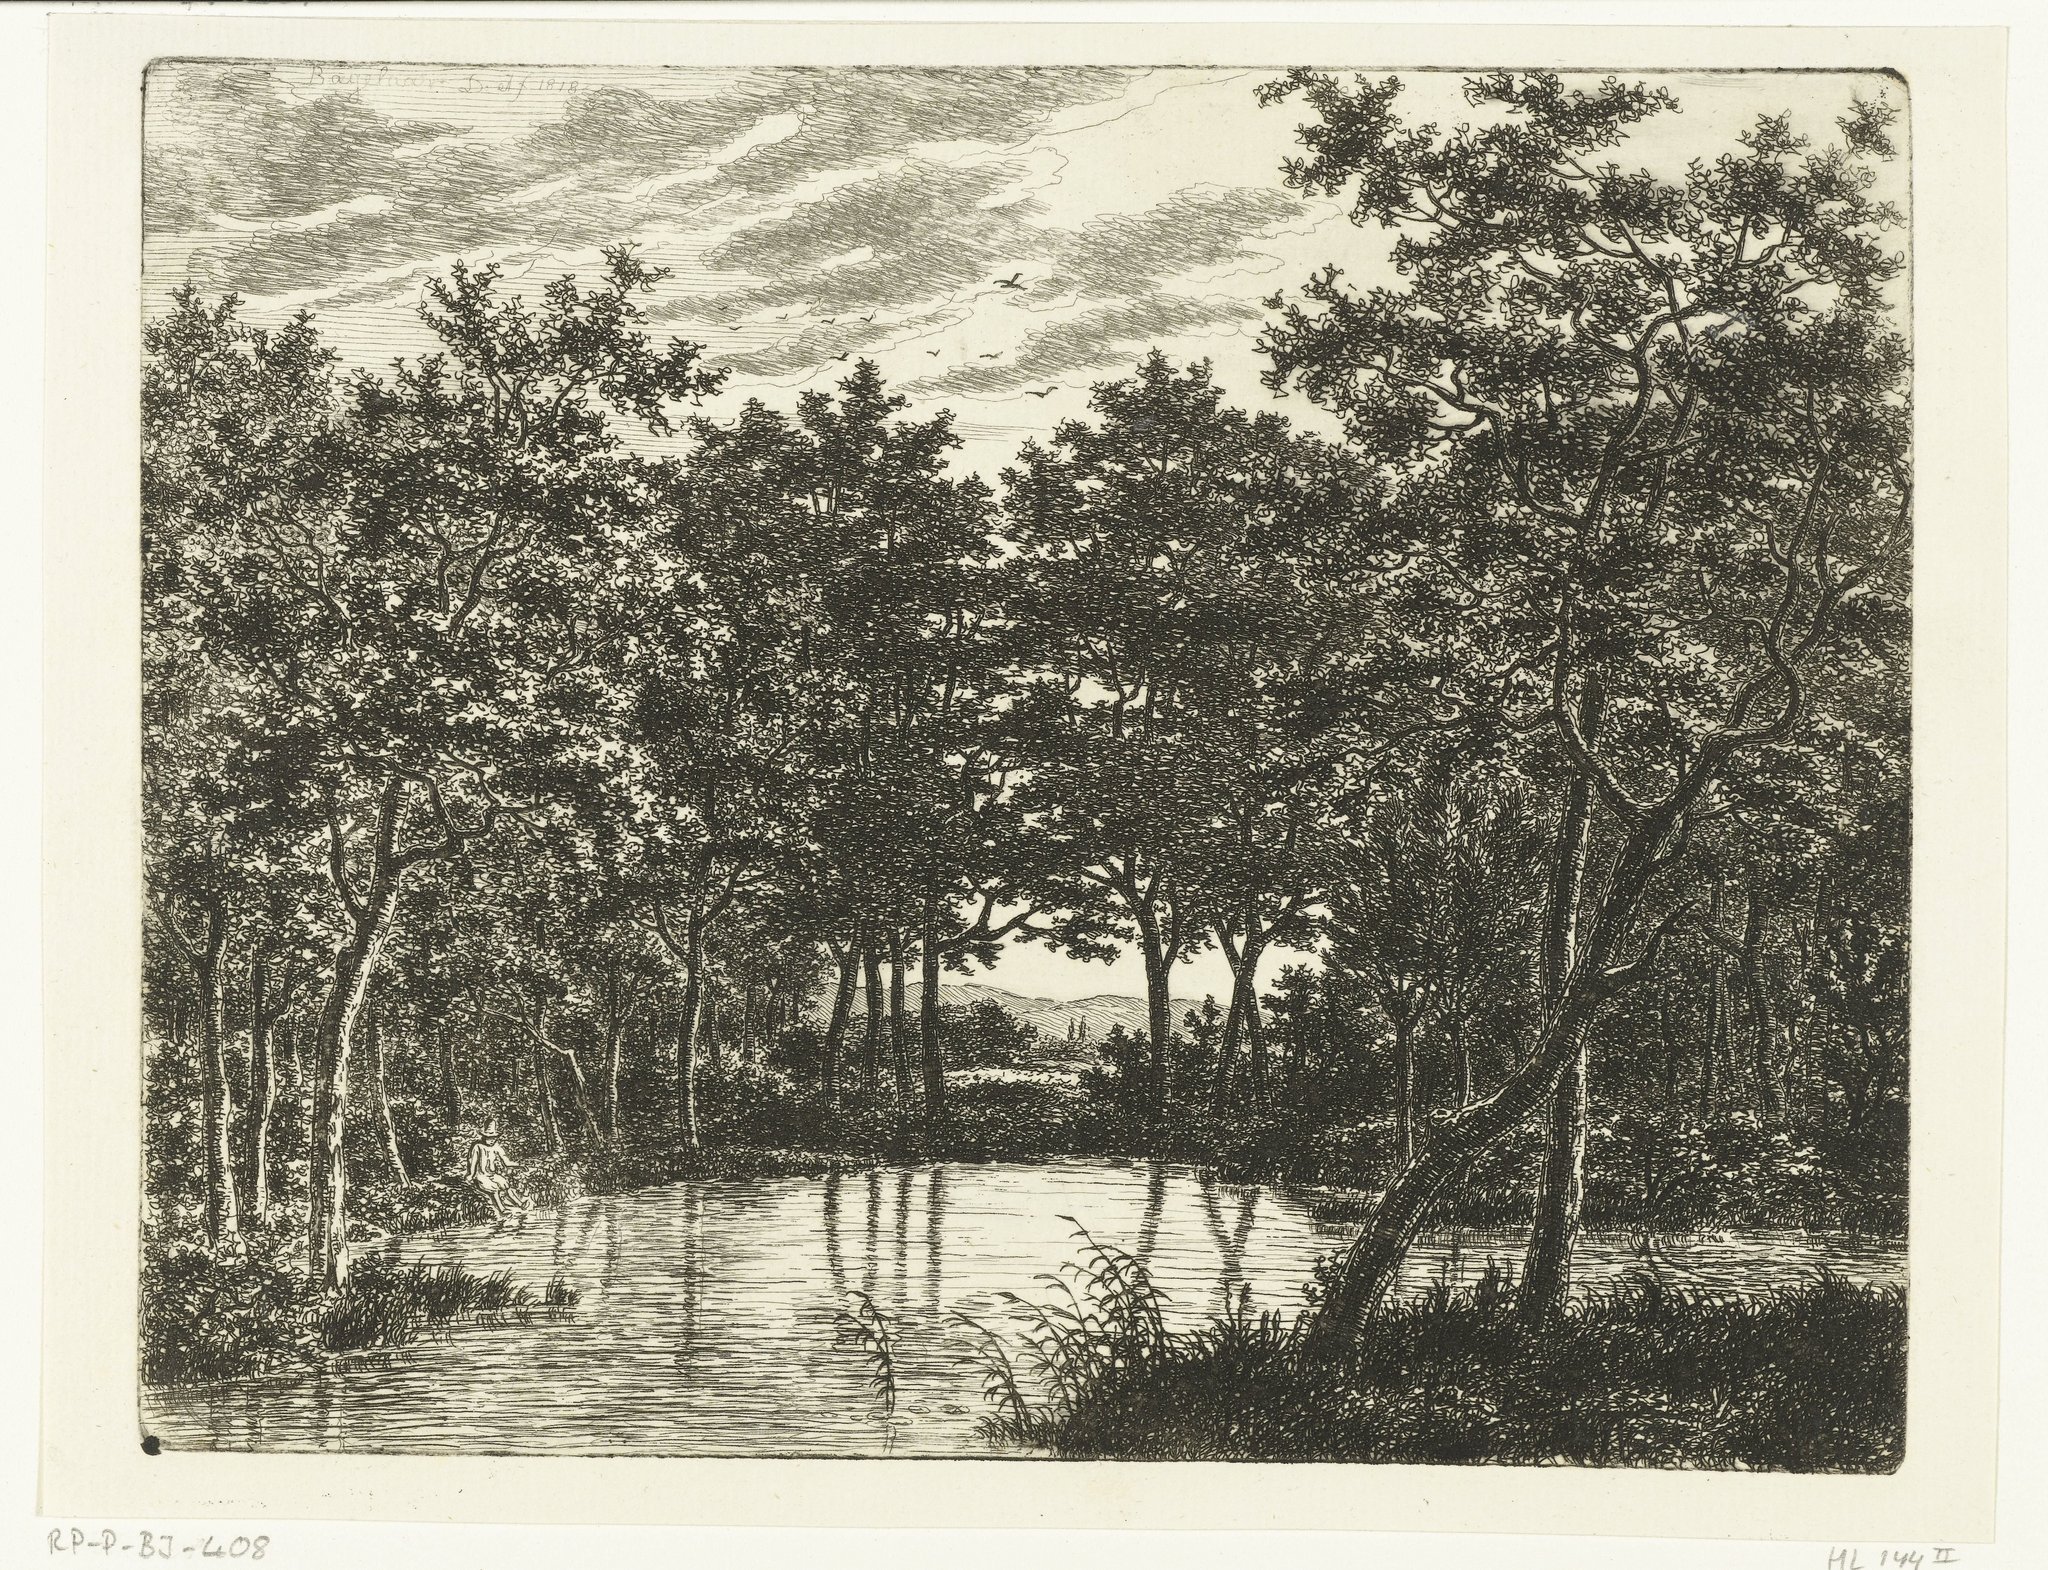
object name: print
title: Landschap met vijver, links zit een visser met puntige hoed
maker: ernst willem jan bagelaar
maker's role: draughtsman, print maker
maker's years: 1775-1837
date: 1818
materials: paper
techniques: drypoint, etching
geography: netherlands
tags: pond, pool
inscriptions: collector's mark: Lugt 2228